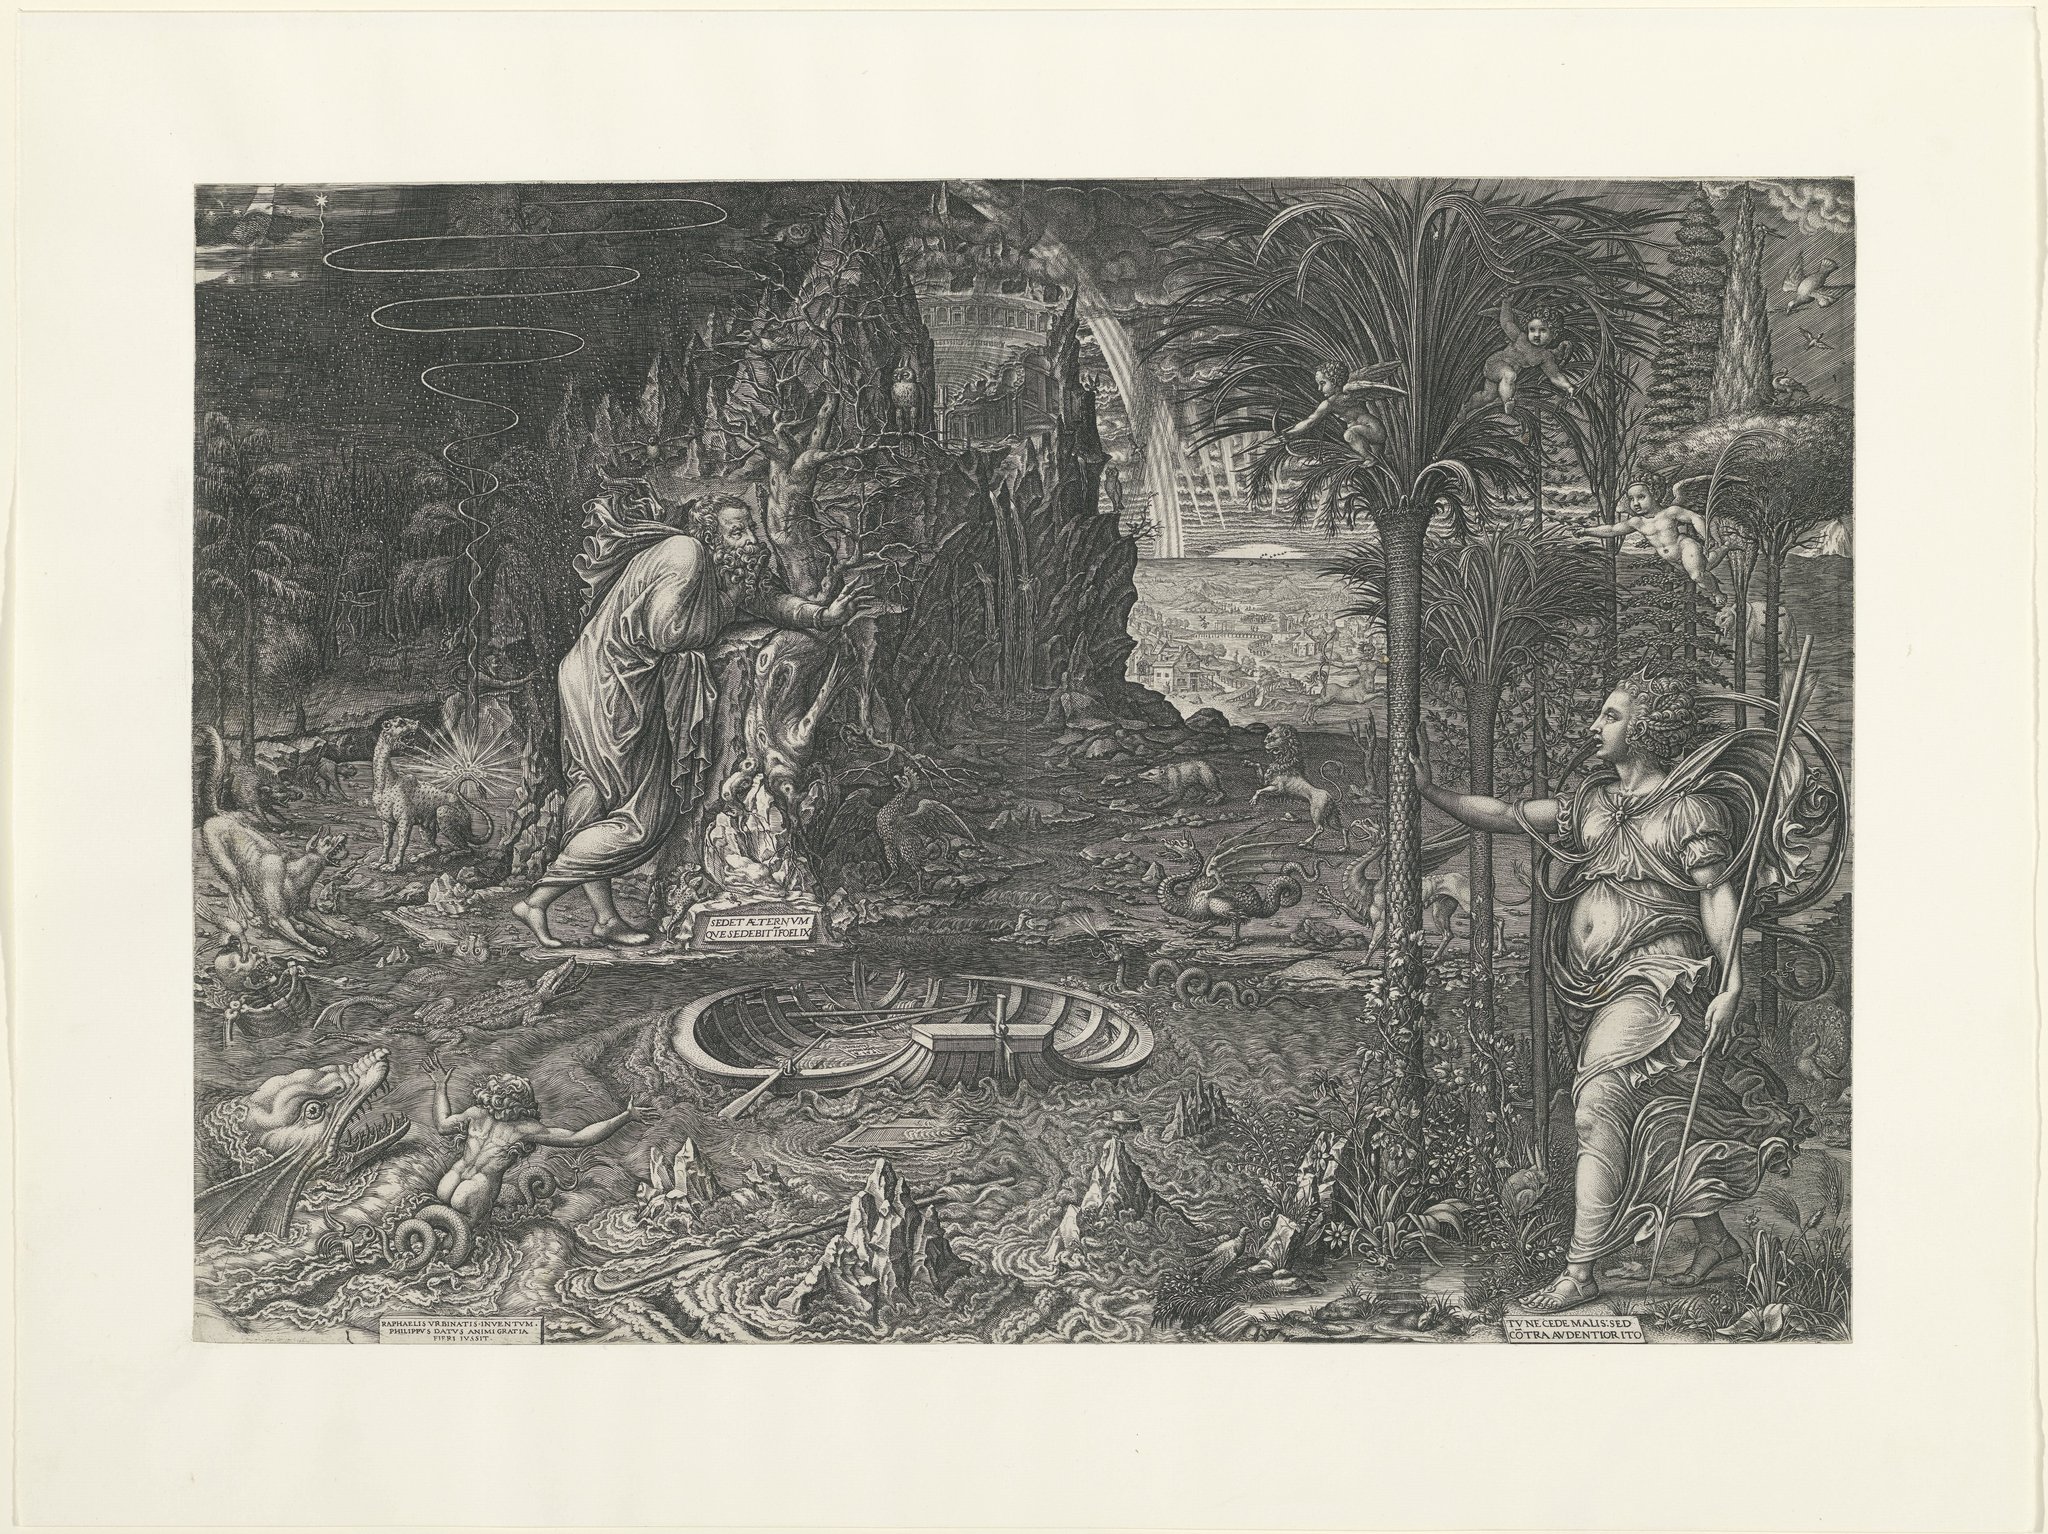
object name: print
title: Allegorie van het Leven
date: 1561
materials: paper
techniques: engraving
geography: italy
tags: animals, mis-shapen animals; monsters, landscapes - hh - ideal landscapes, life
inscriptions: collector's mark: Lugt 240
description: Fantasielandschap bij nacht met rotsen, wilde dieren, verschillende soorten bomen en een woest meer met zeemonsters en een roeiboot. Aan de rand van het meer staat een oude man met baard, leunend tegen een rots en een dode boom. De oude man kijkt over het water naar een vrouw met kroon en speer op de voorgrond rechts.